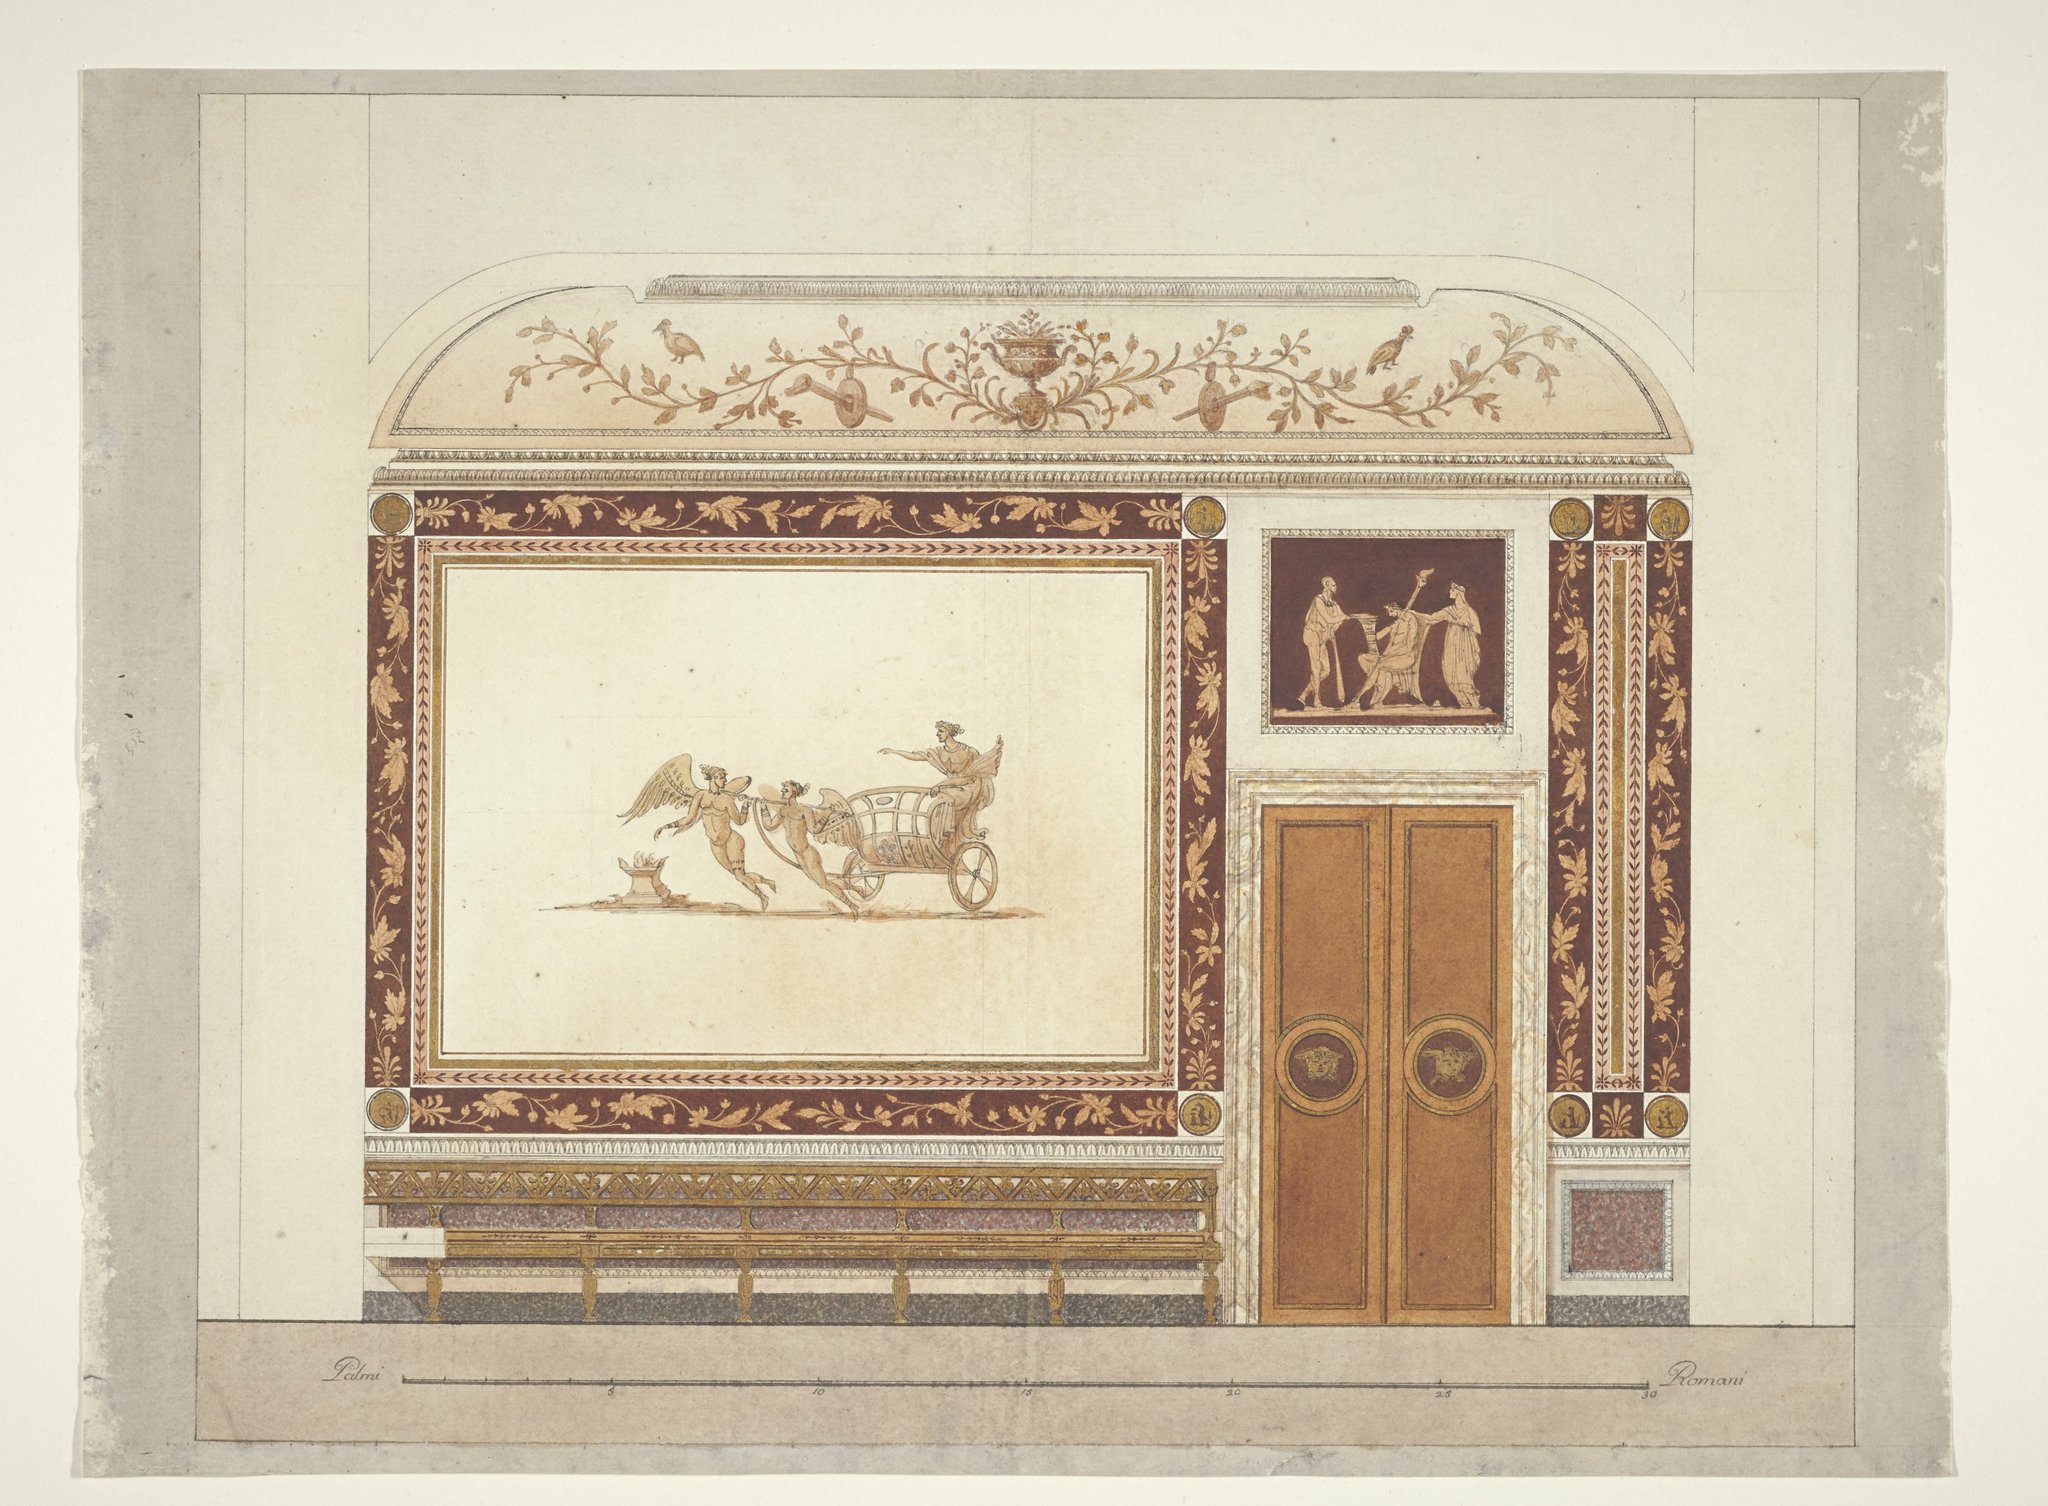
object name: drawing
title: Ontwerp voor een kamerwand in Etruskische stijl met een zitbank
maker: Anonymous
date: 1790-1795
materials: gold, paper, pencil, watercolor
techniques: brush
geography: rome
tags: interior of the house, wall-covering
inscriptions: : Aan de onderzijde schaal in 'Palmi Romani; watermerk D&C BLAUW en gekroond medaillon met staande leeuw met pijlenbundel en het opschrift VRYHEYT, randschrift PROPATRIA/ESUSQUE/LIBERTATE.